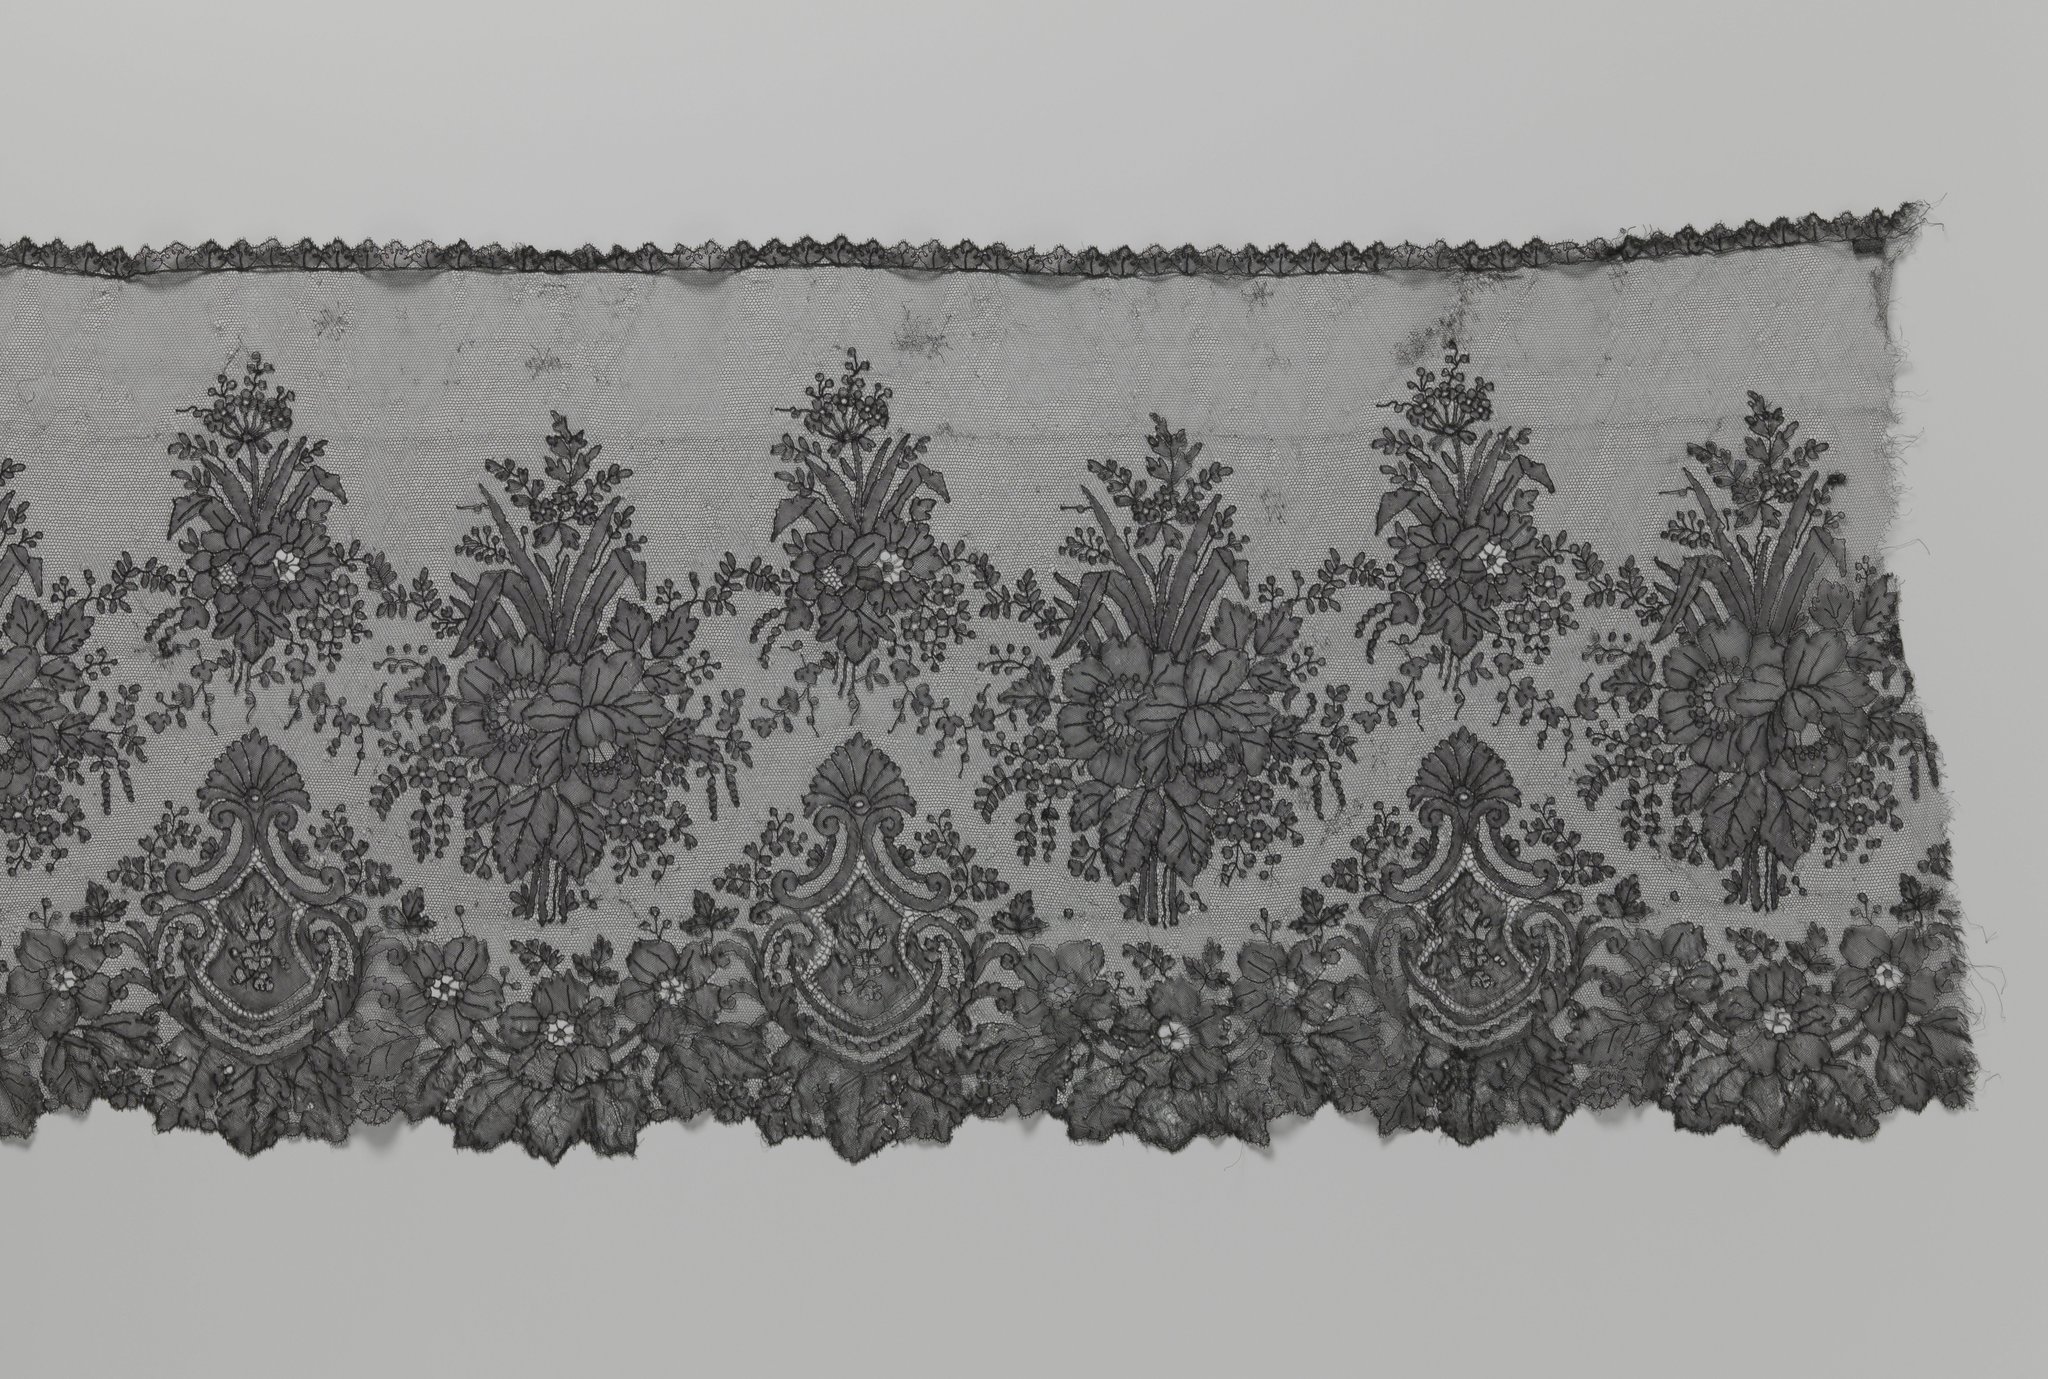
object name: strip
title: Japonstrook van kloskant met schildvormige medaillons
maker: Anonymous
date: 1850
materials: silk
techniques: lace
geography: bayeux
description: Japonstrook van zwarte kloskant: Chantilly-kant. Op een open mazenfond staan gesloten motieven los van elkaar gegroepeerd. Op de knooppunten der schulpen rijzen drie symmetrische schildvormige medaillons op, die gevat zijn in twee paar c-voluten. Boven de schulpen komt een grote, boven de medaillons een kleine bloemtoef voor, met geknakte bloembladeren als bekroning. De binnenrand is versierd met een keten van hartvormige blaadjes.